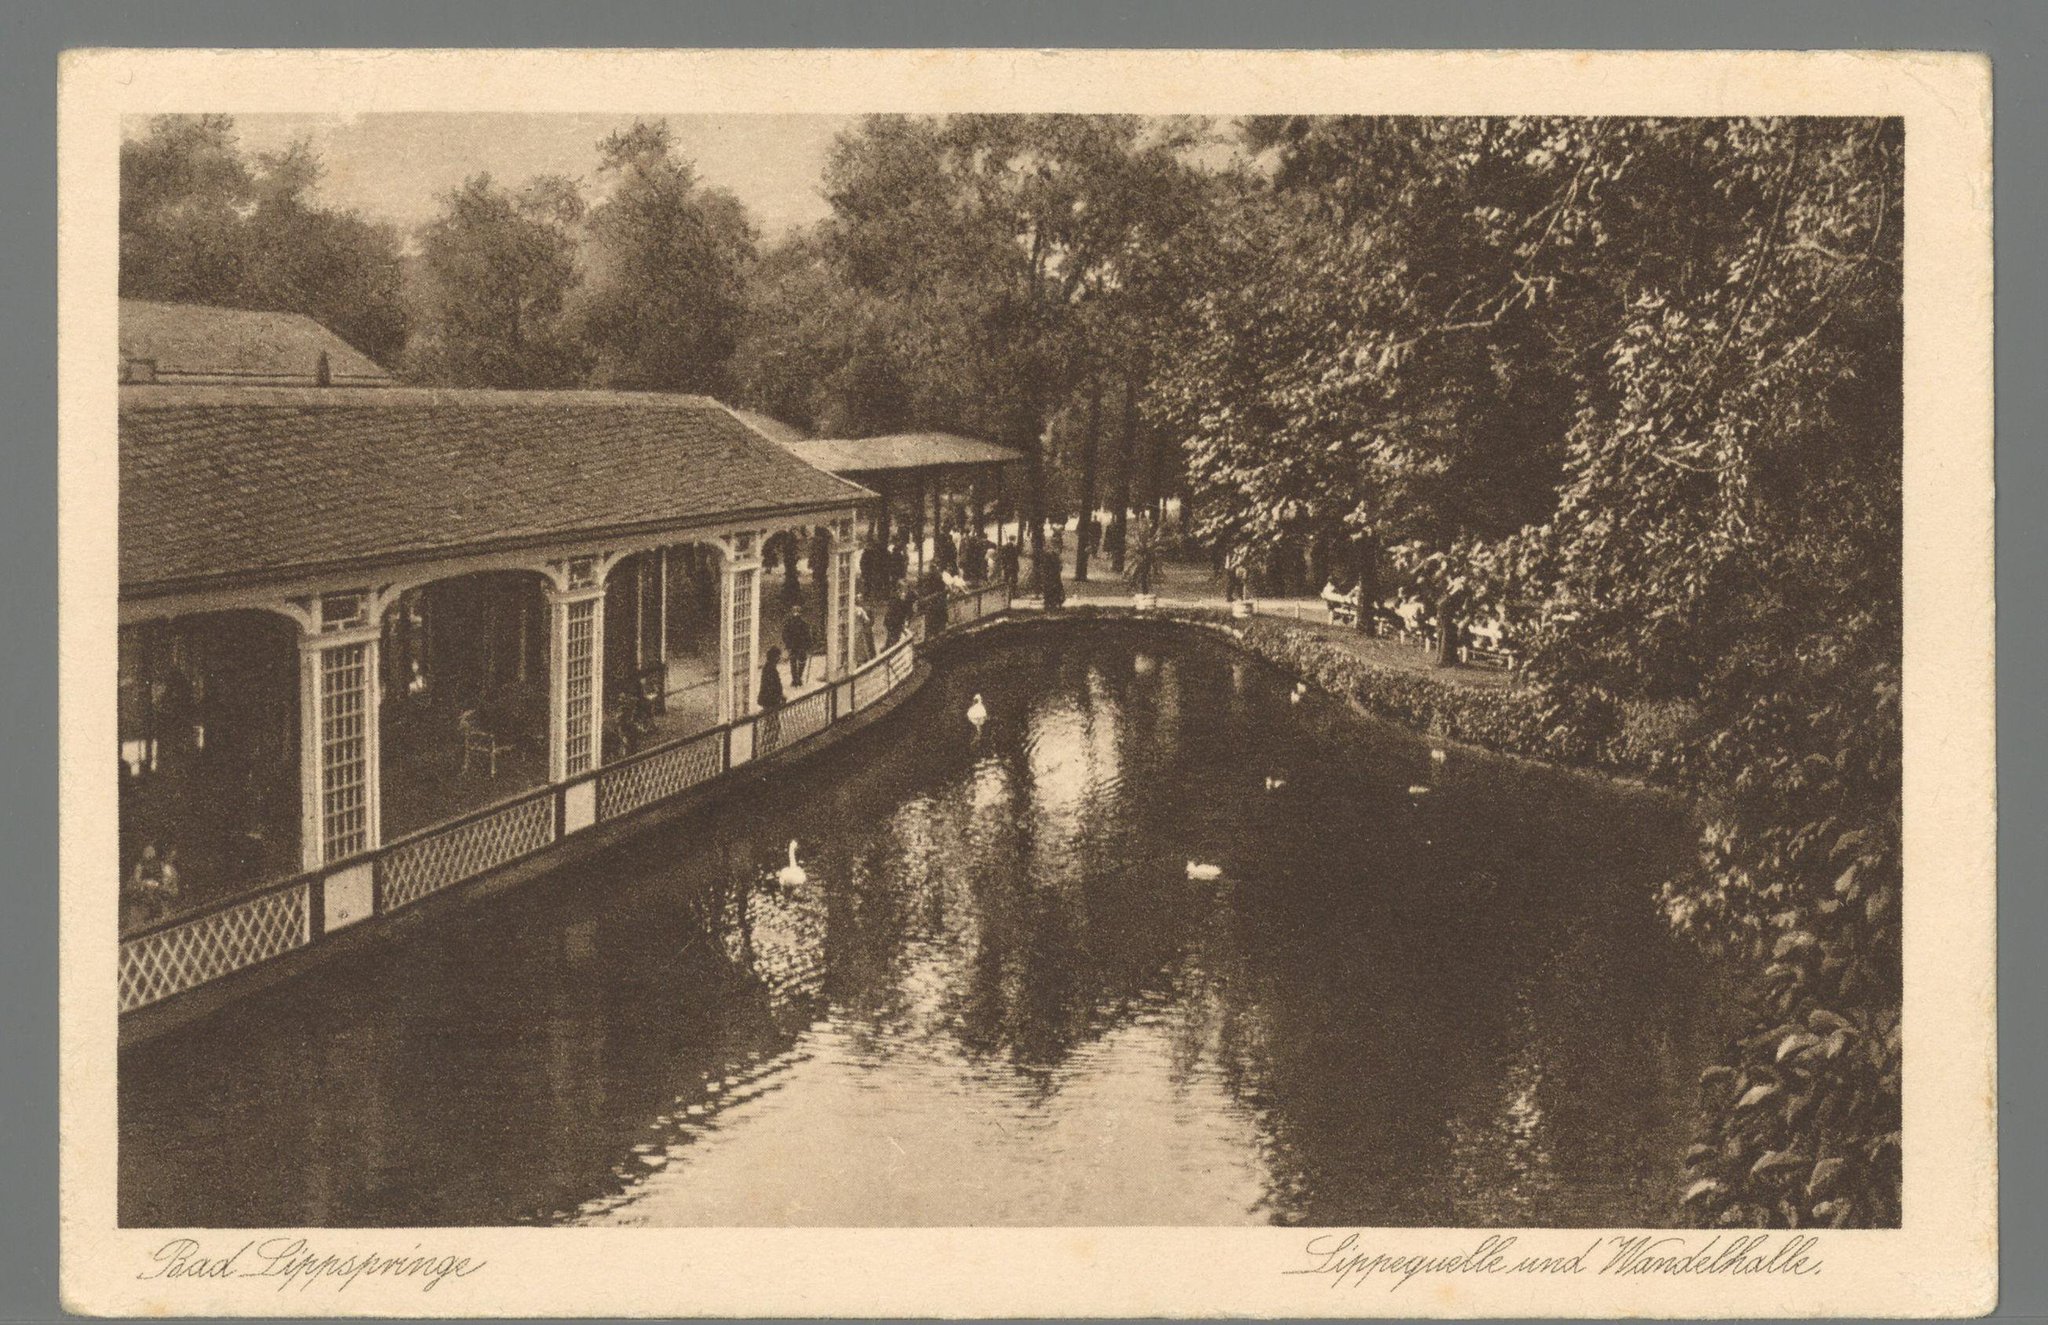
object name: photomechanical print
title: Bad Lippspringe. Lippequelle und Wandelhalle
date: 1905-1930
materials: cardboard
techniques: rotogravure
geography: bad lippspringe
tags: park, watering-place, spa, pond